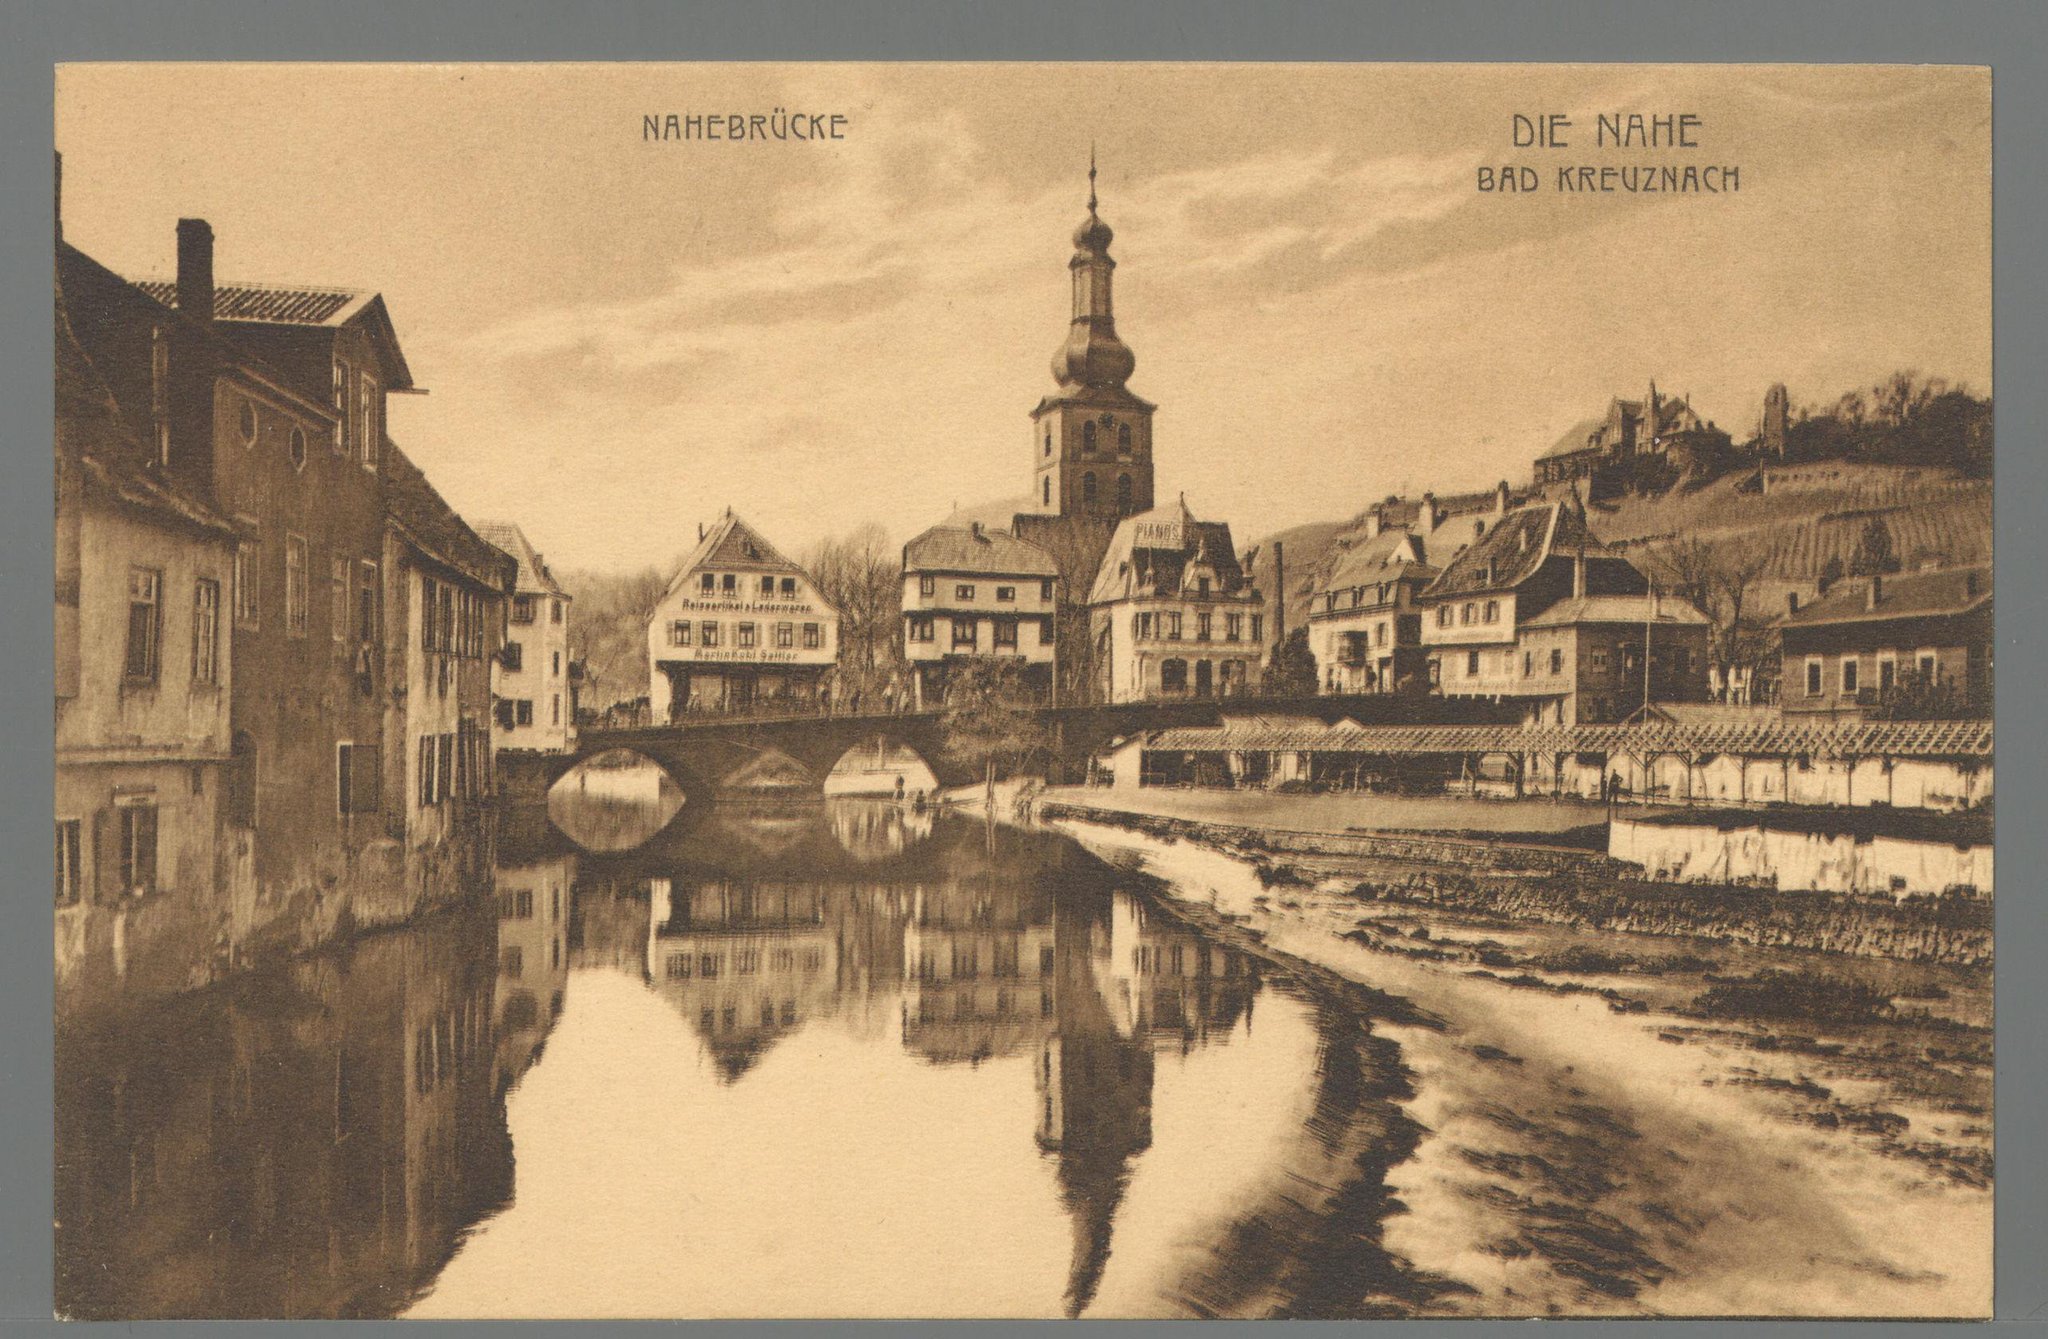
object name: ansichtkaart, prentbriefkaart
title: Nahebrücke. Die Nahe. Bad Kreuznach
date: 1907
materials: cardboard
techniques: photograph, writing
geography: bad kreuznach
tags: city-view, and landscape with man-made constructions, canals, waters (in city), bridge in city across river, canal, etc.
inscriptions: date